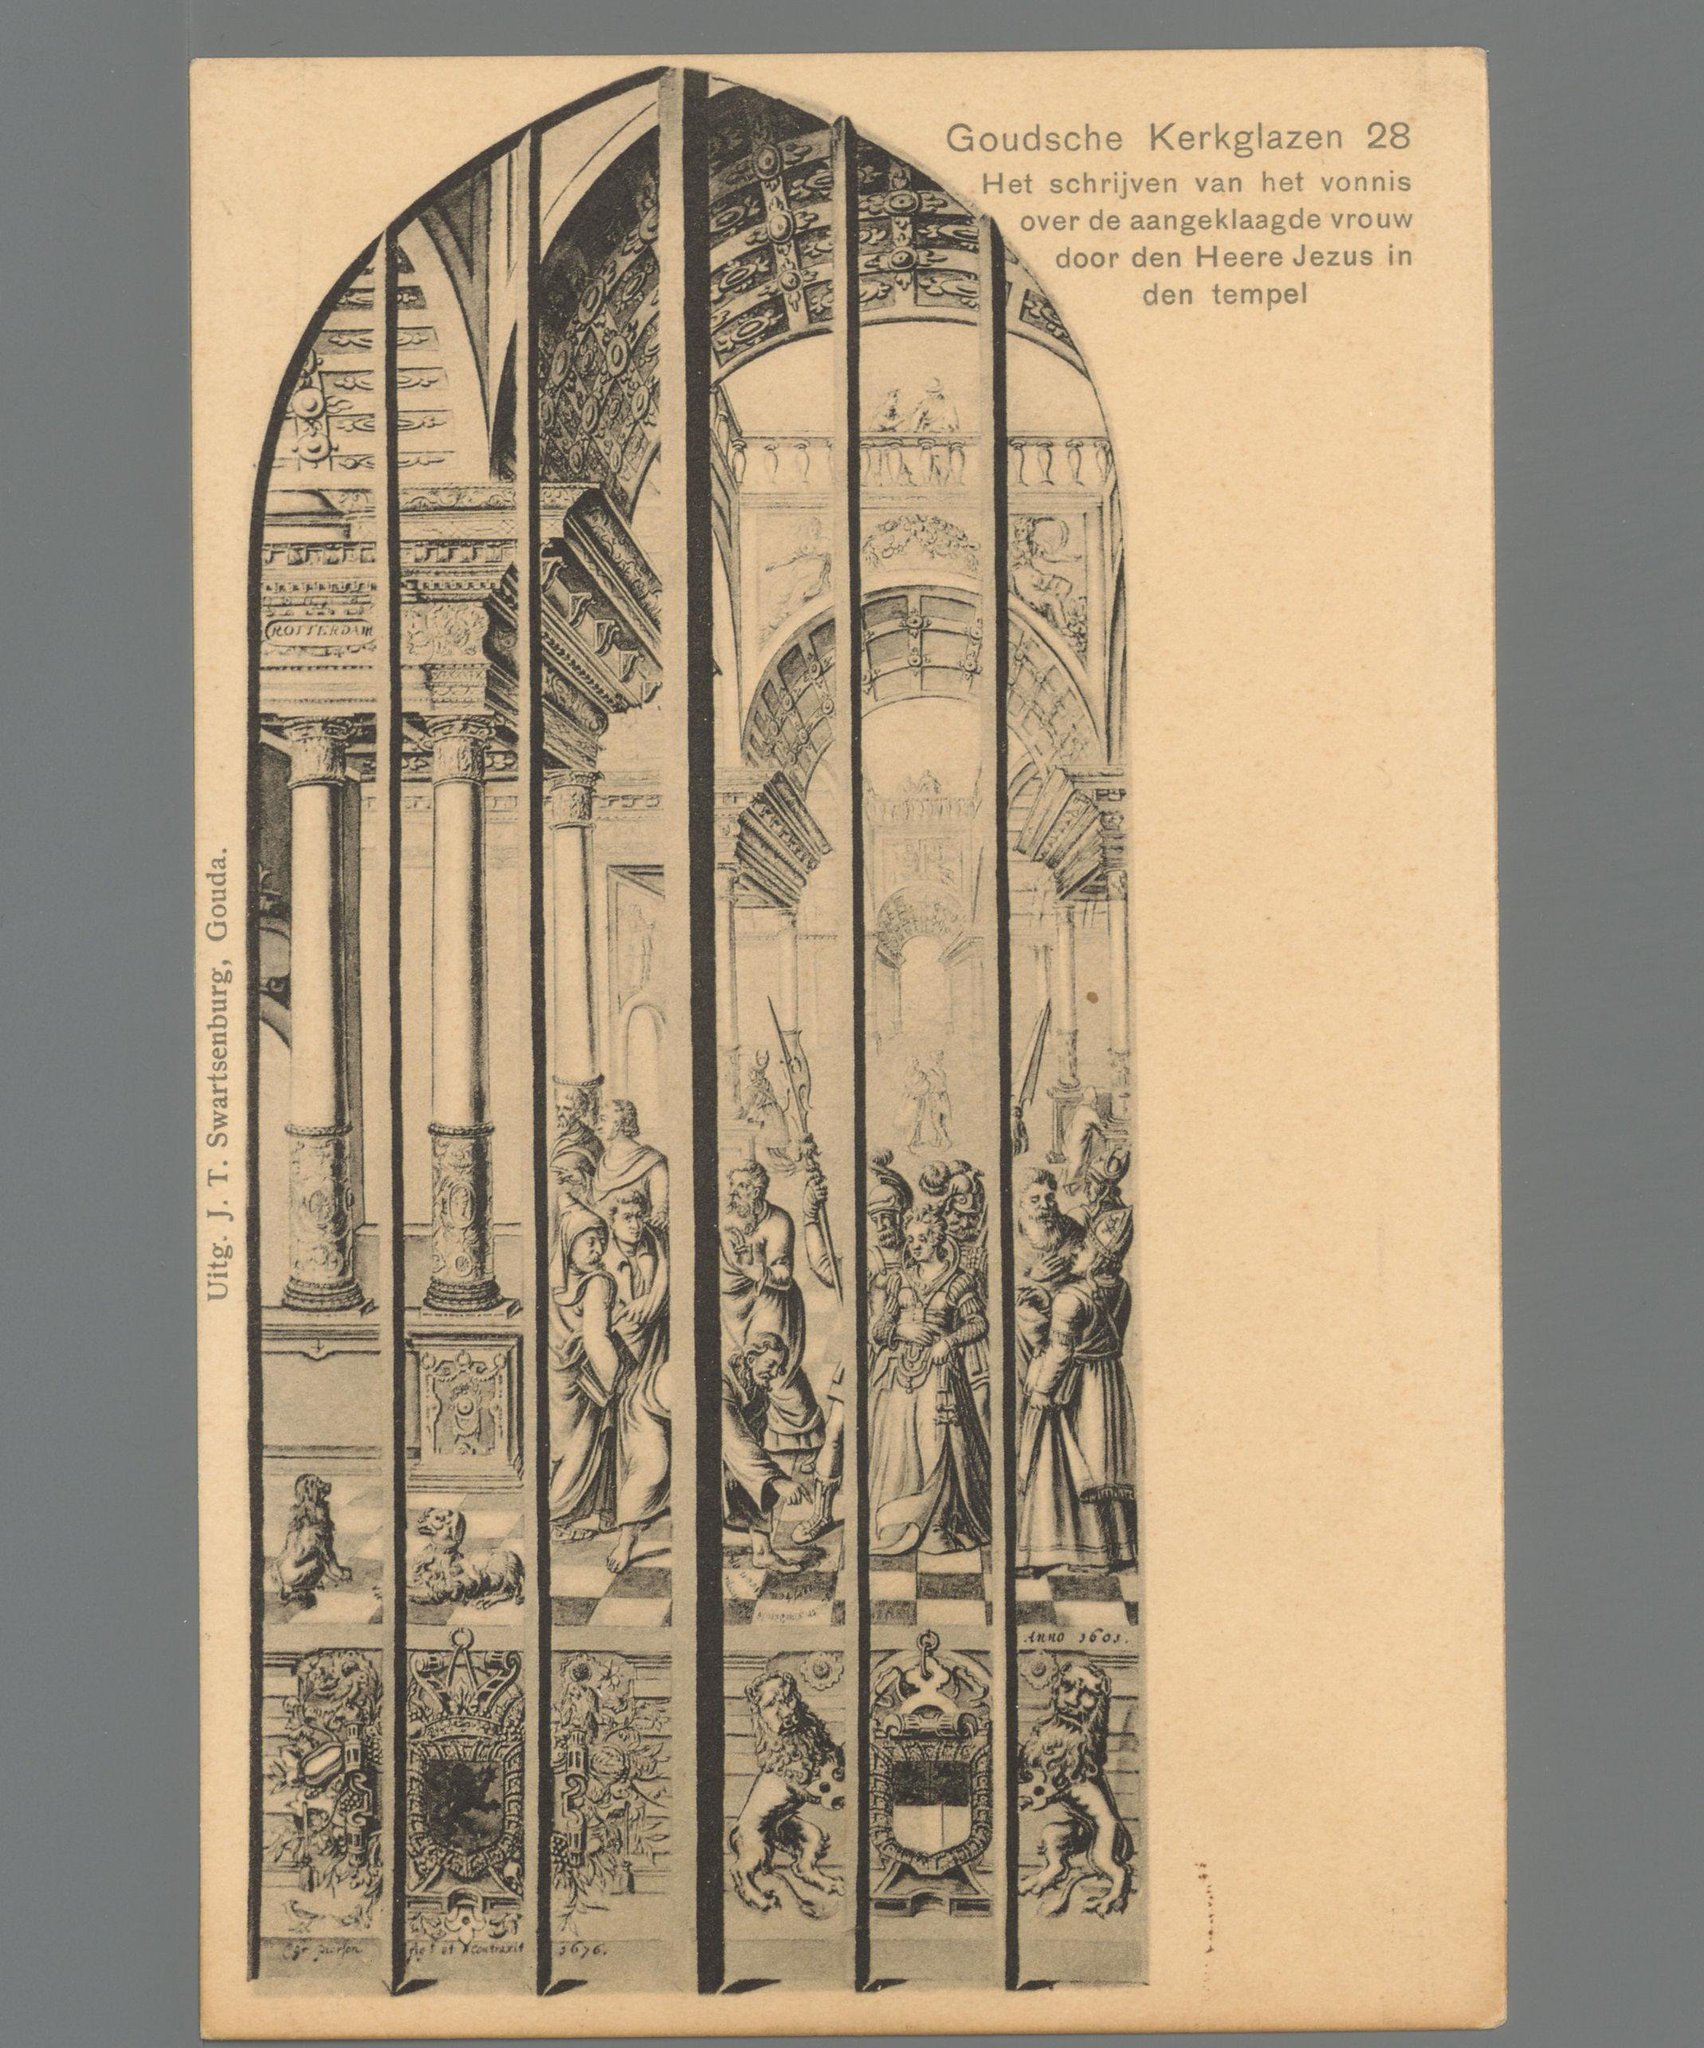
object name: ansichtkaart, prentbriefkaart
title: Goudsche Kerkglazen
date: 1892-1905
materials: cardboard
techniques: photograph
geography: gouda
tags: church-window, e.g. rose-window, gouda